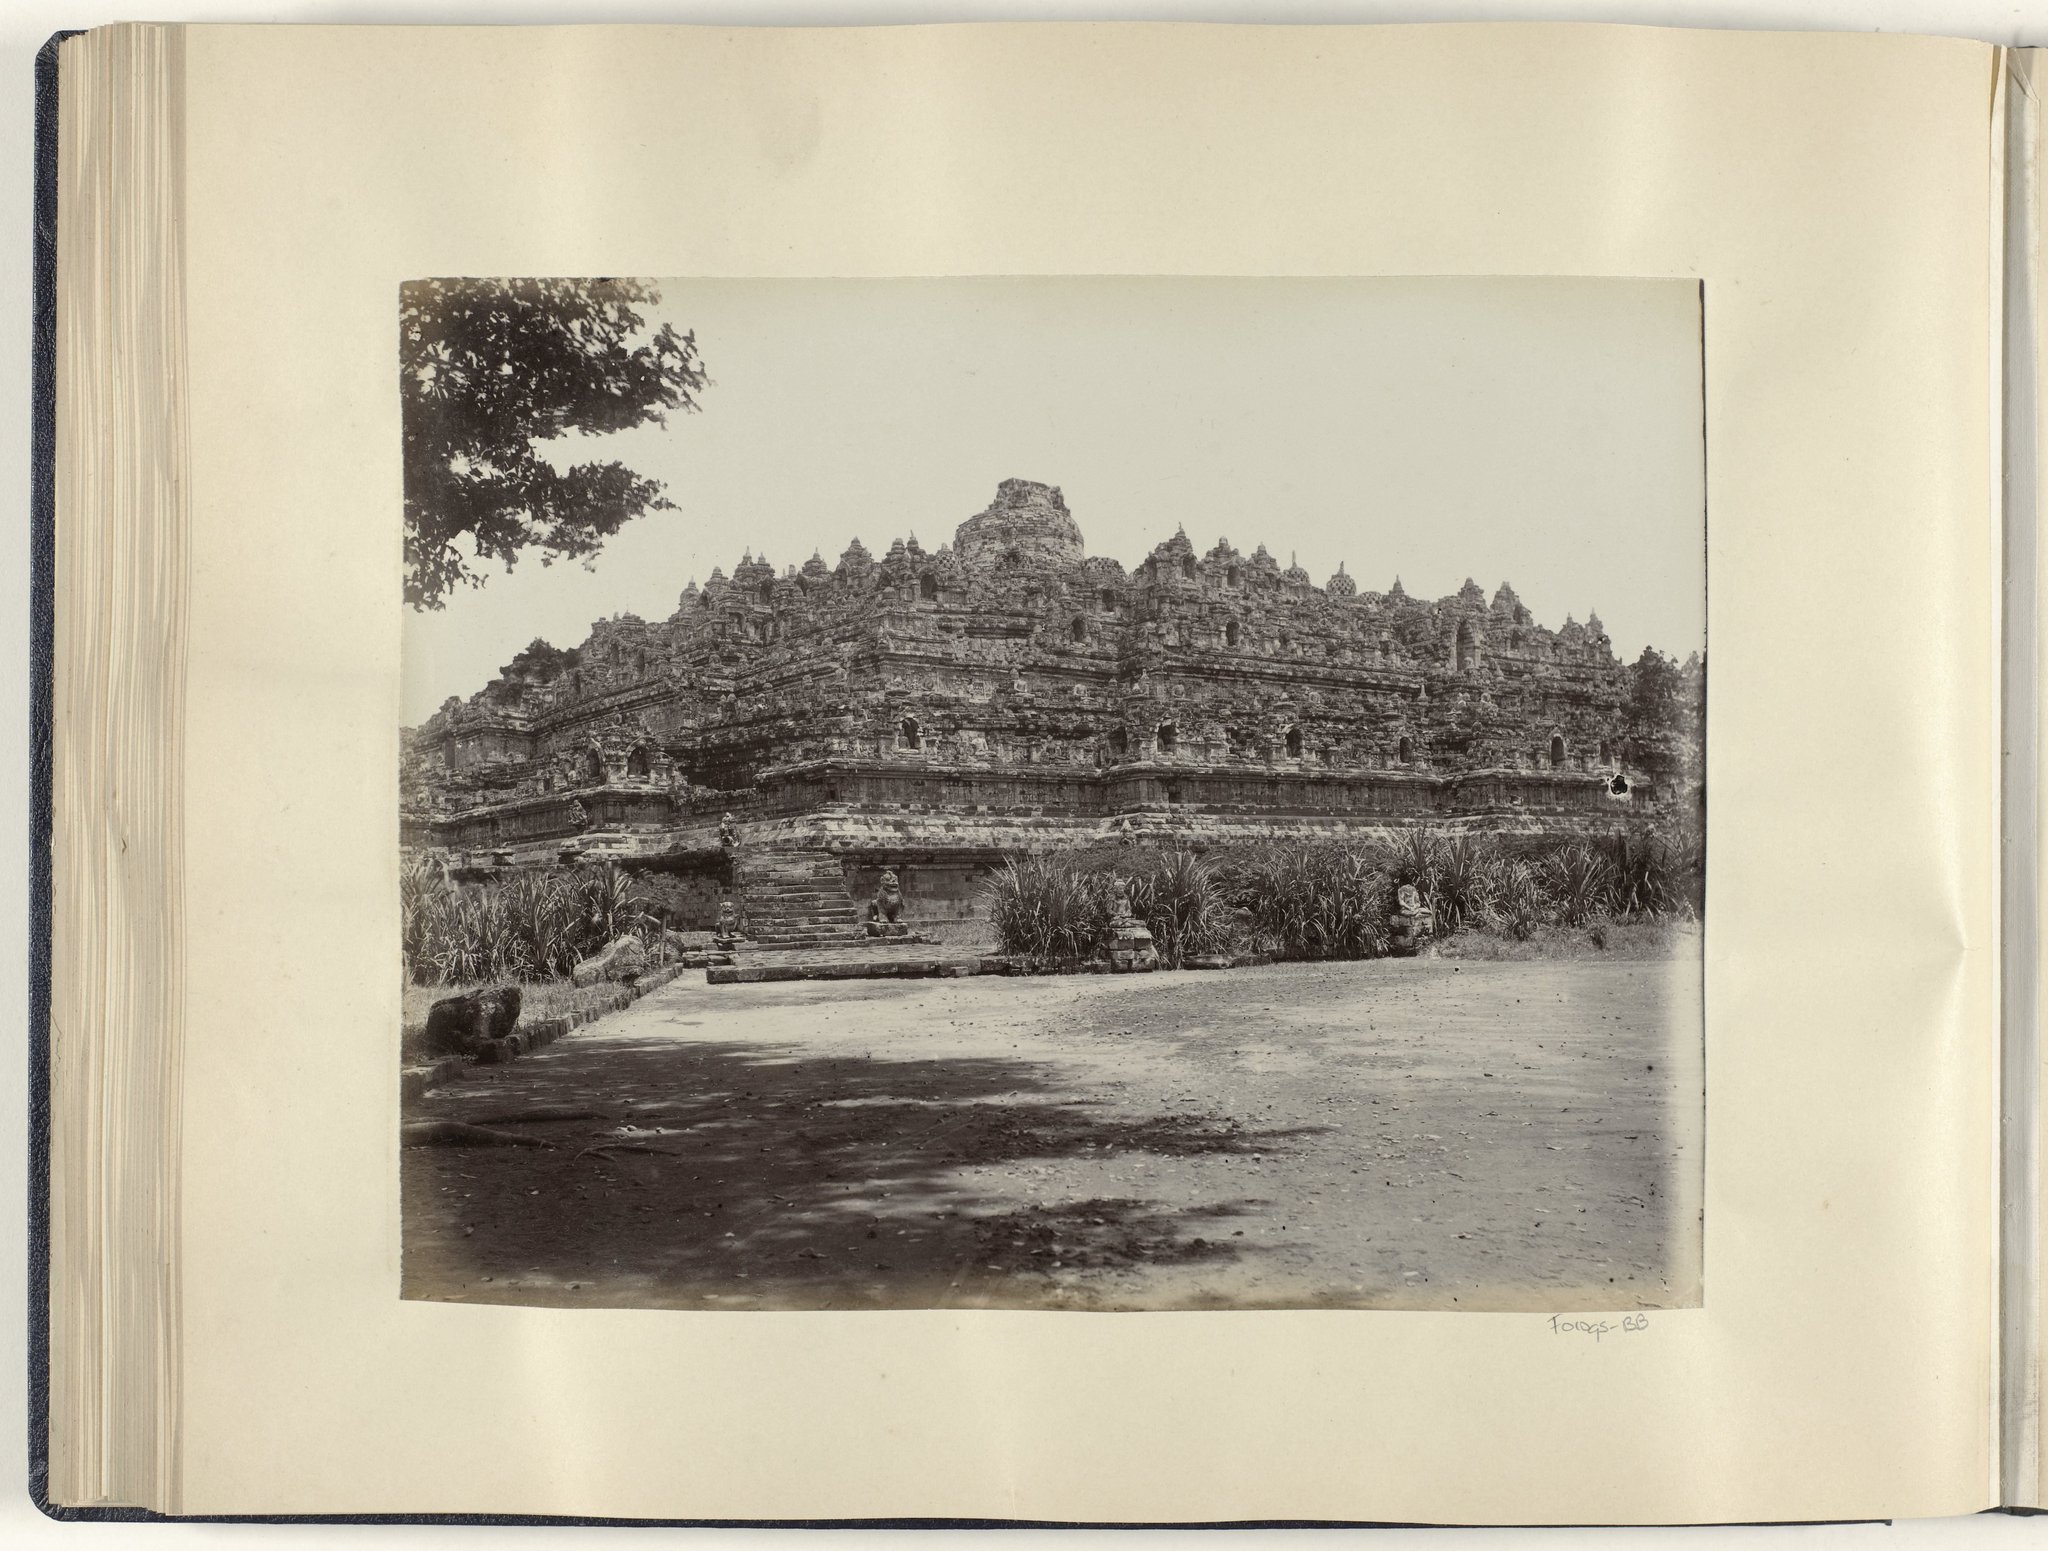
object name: photograph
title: Borobudur op Java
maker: Anonymous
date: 1895-1905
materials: paper, photographic support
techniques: albumen print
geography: borobudur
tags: temple, shrine ~ hinduism, buddhism, jainism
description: Onderdeel van Reisalbum met foto's van bezienswaardigheden in Italië, Zwitserland en Nederlands-Indië.